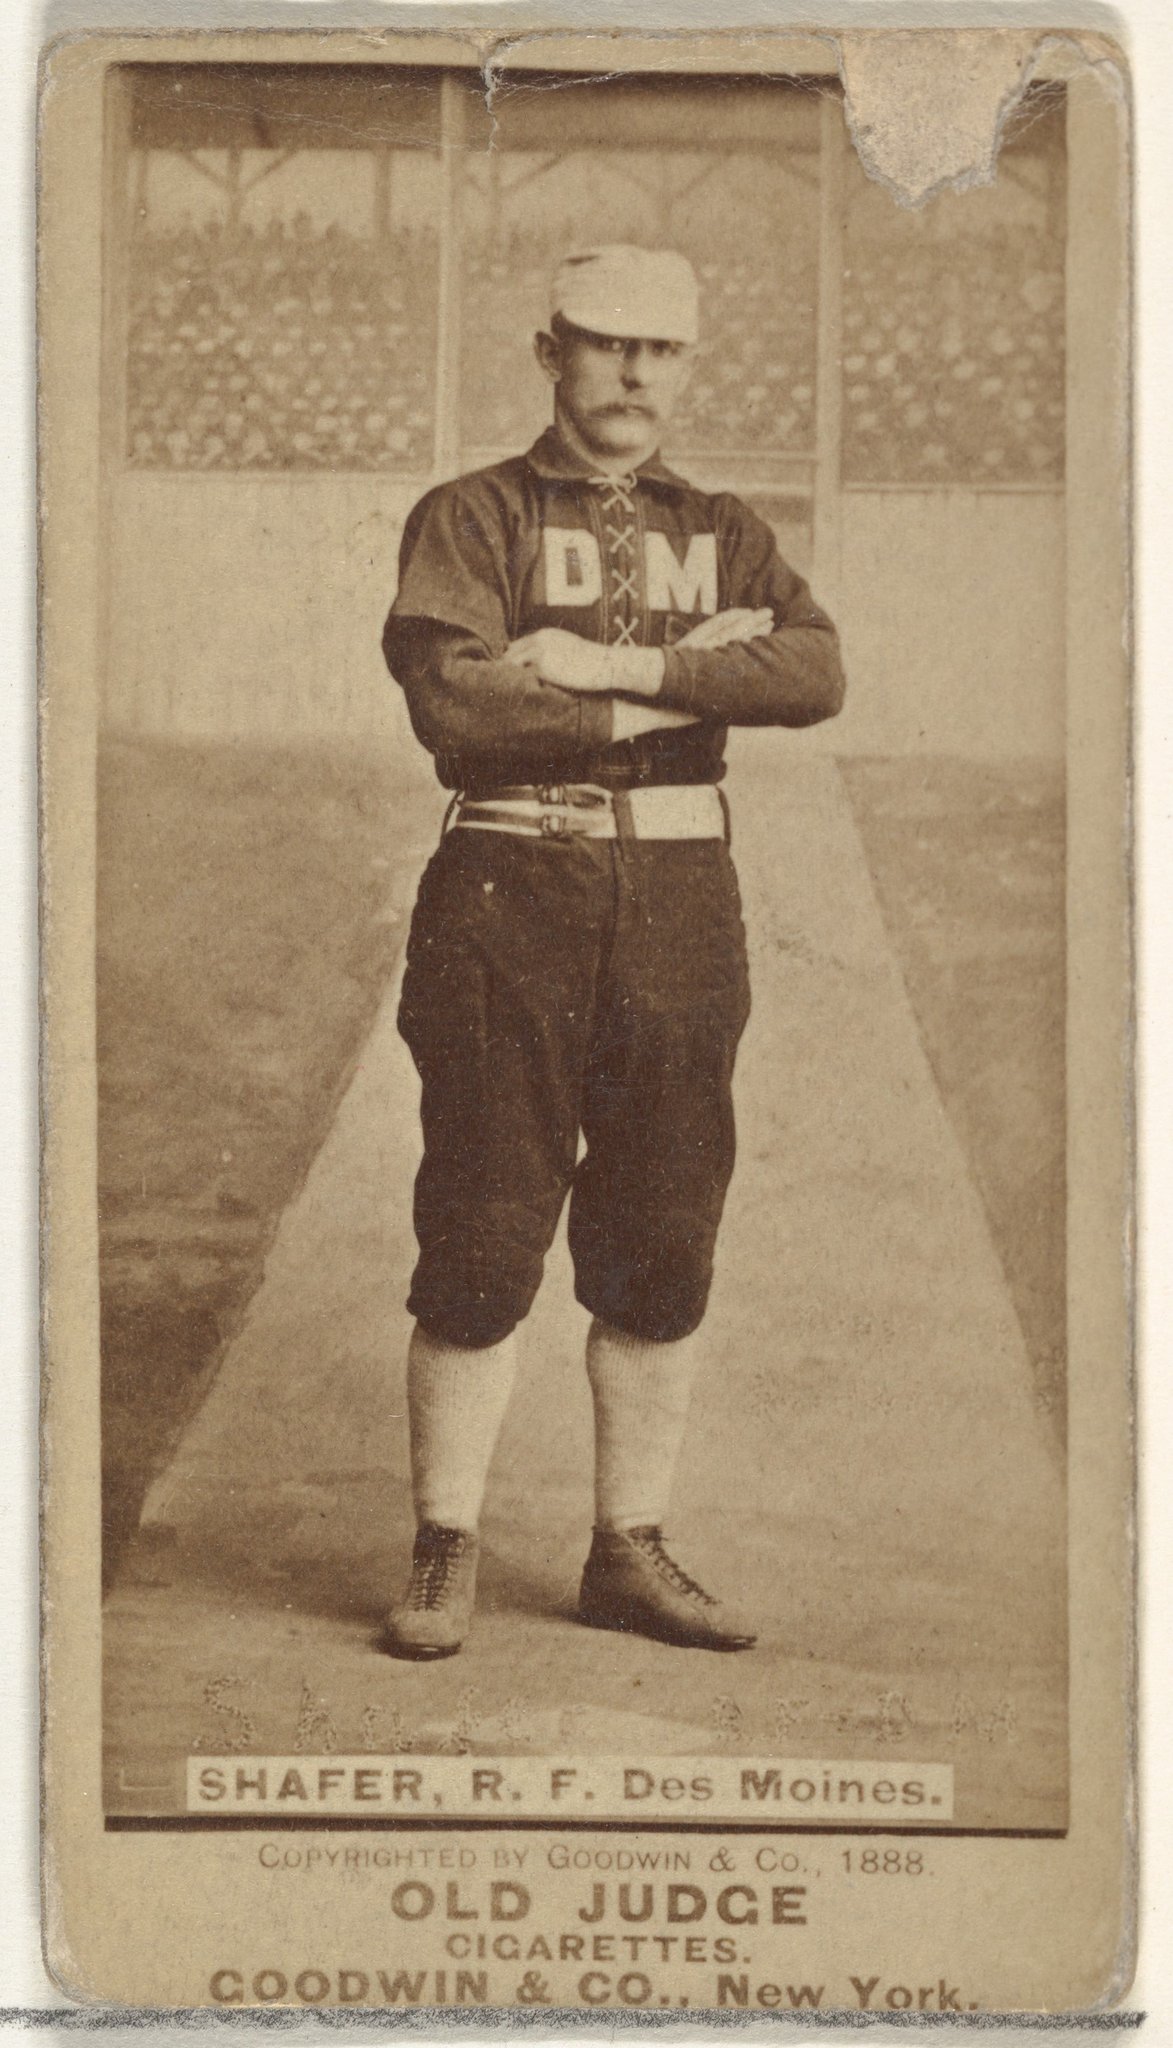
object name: baseball card, photograph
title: George W. Shafer, Right Field, Des Moines Prohibitionists, from the Old Judge series (N172) for Old Judge Cigarettes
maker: goodwin & company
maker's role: publisher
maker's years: 1850-1950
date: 1888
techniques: albumen silver print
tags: men,portraits,baseball,athletes